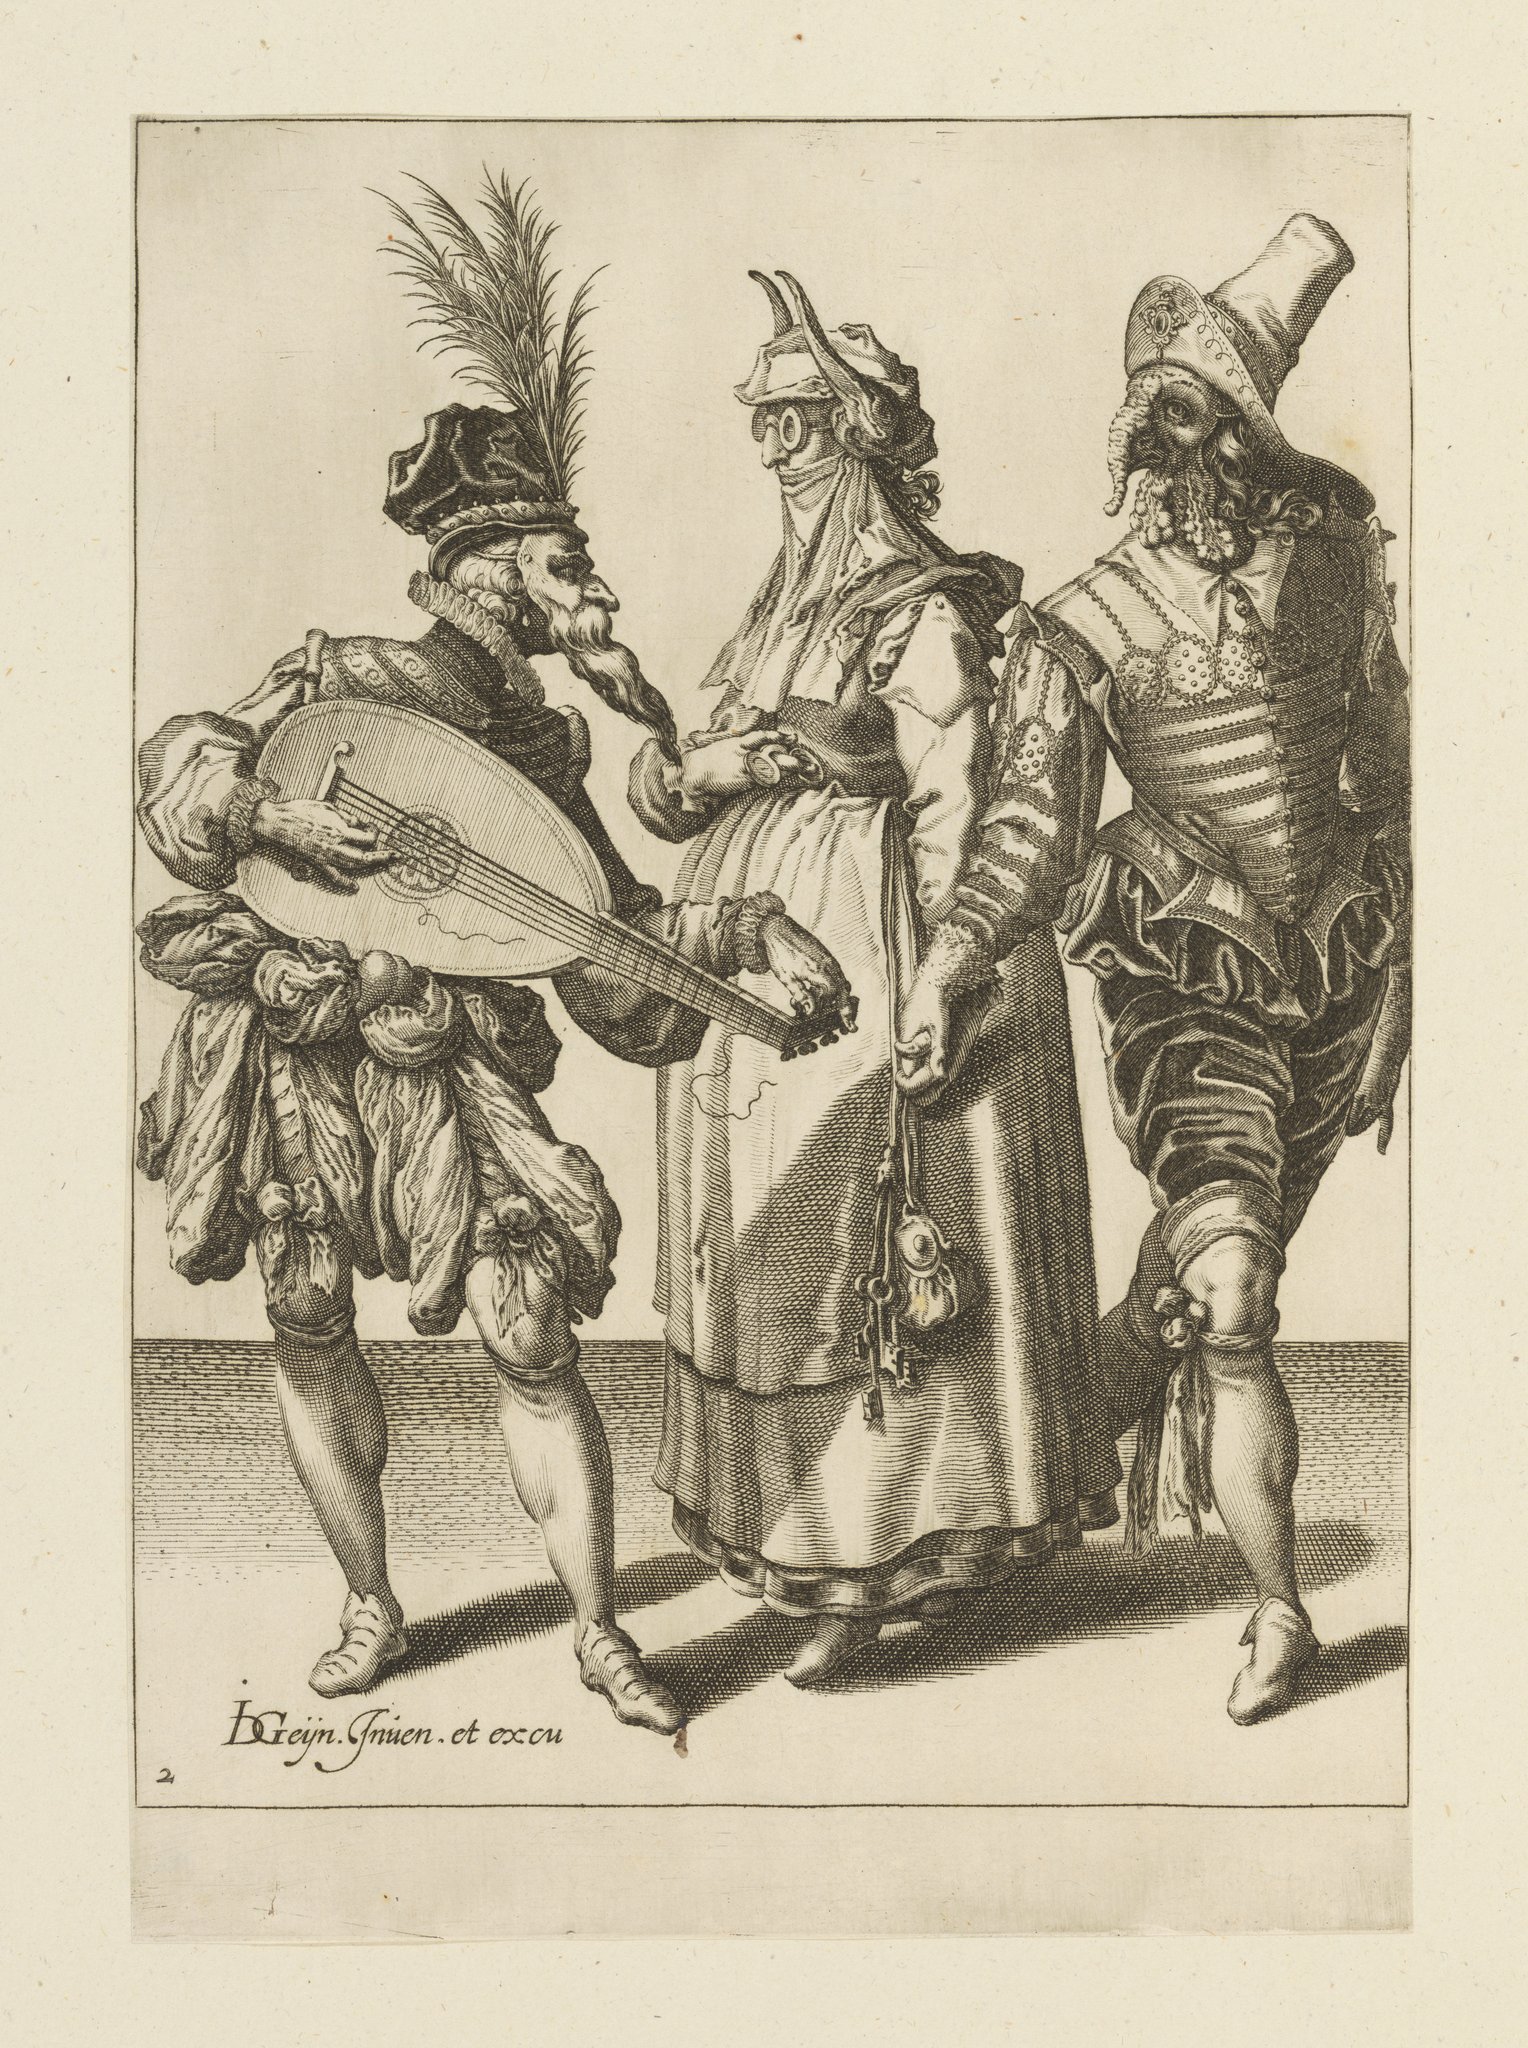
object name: print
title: A Couple Addressed by a Lute Player, plate 2 from "The Masquerades"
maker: jacques de gheyn (ii)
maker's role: artist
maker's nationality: netherlandish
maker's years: 1565-1629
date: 1595-1596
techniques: engraving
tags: musical instruments,masks,men,women,lutes